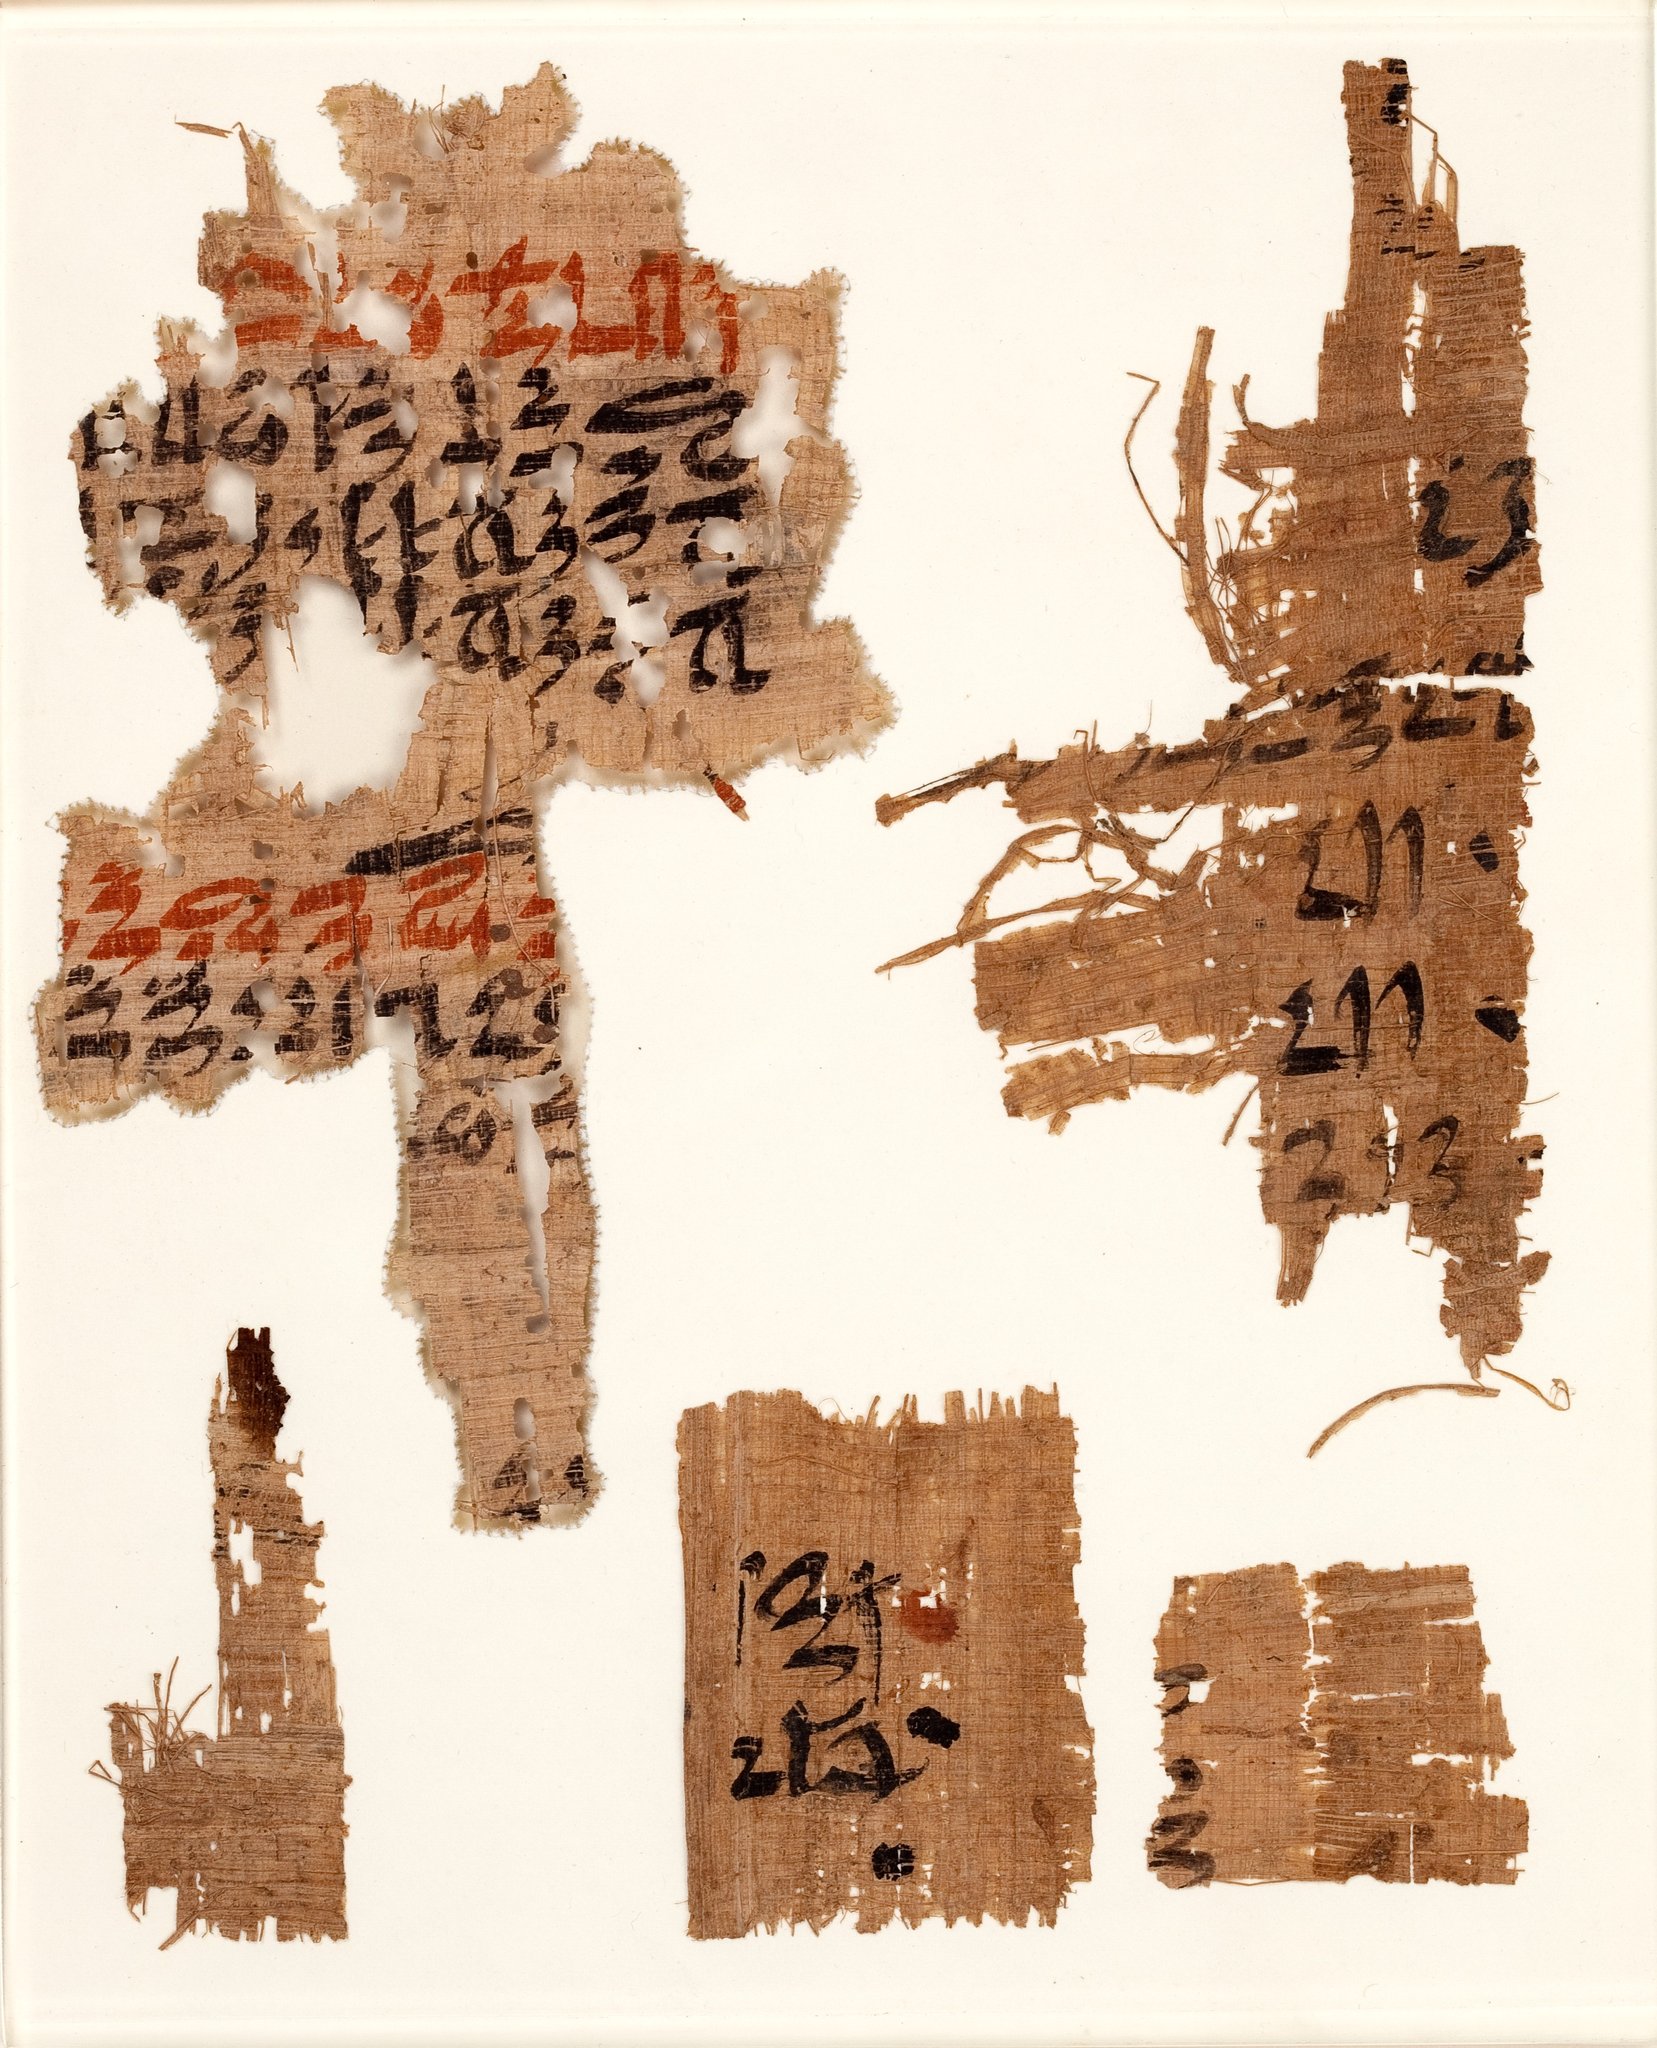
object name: papyrus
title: Two papyrus fragments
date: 1981-1640 BCE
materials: ink, papyrus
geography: egypt